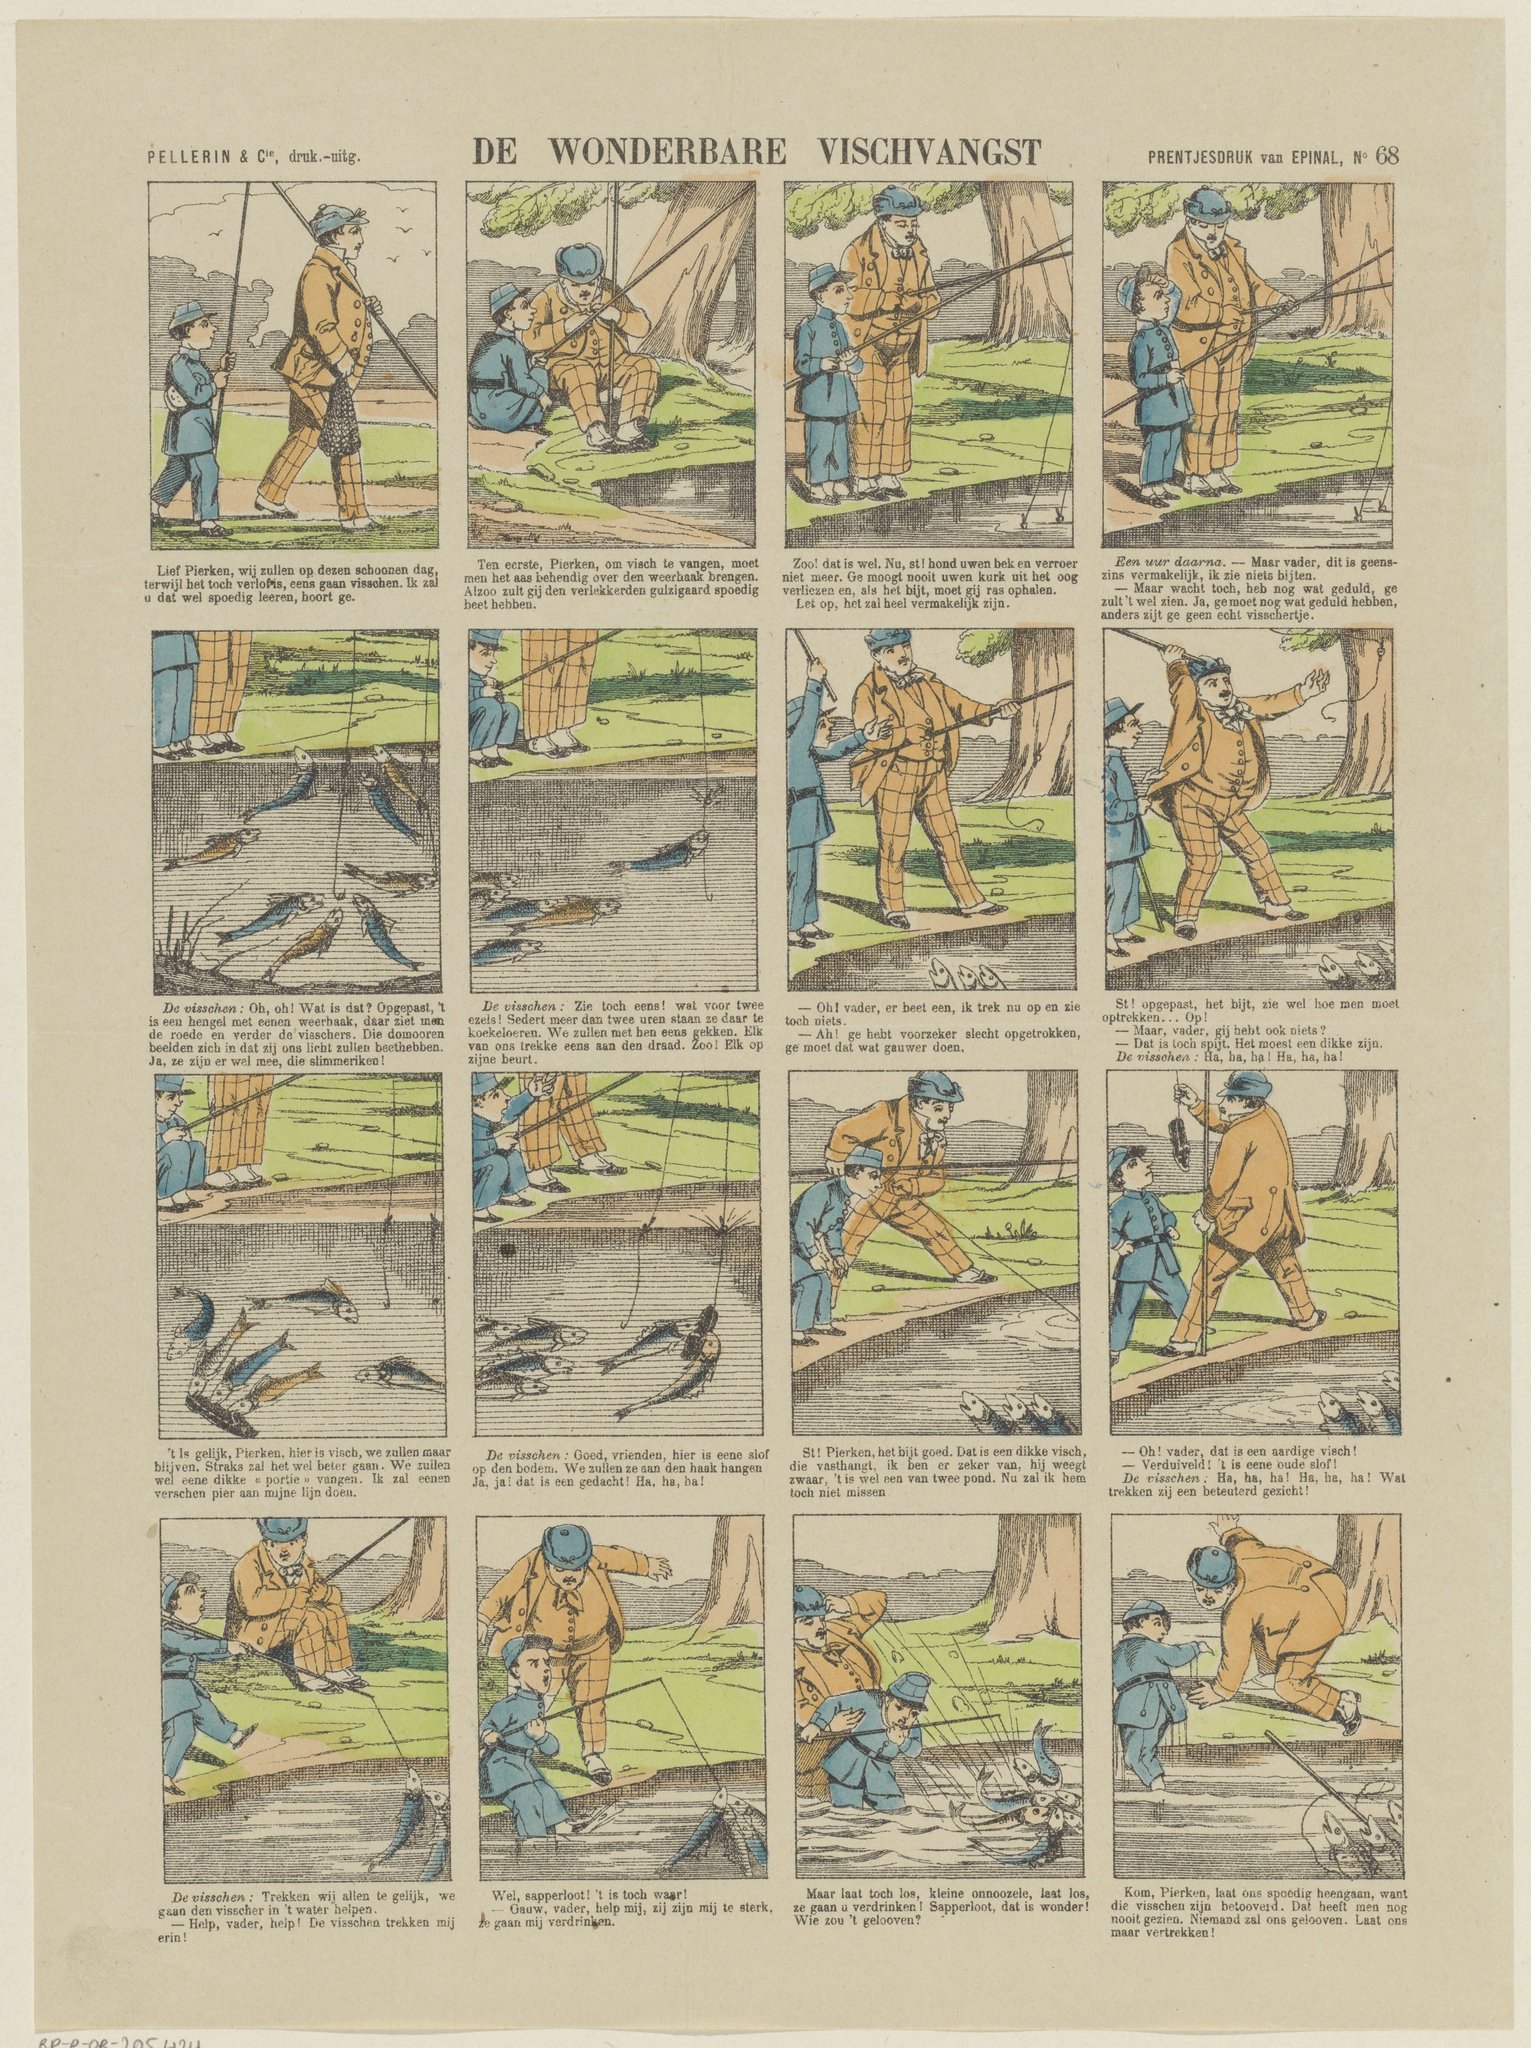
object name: popular print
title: De wonderbare vischvangst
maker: Anonymous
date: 1902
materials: paper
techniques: colour, letterpress printing, lithograph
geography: epinal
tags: fishing (sports), father and son(s) (family group)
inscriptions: collector's mark: Lugt 2760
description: Blad met 16 voorstellingen over Pierken en zijn vader die samen gaan vissen. Onder elke afbeelding een onderschrift. Genummerd rechtsboven: No 68.